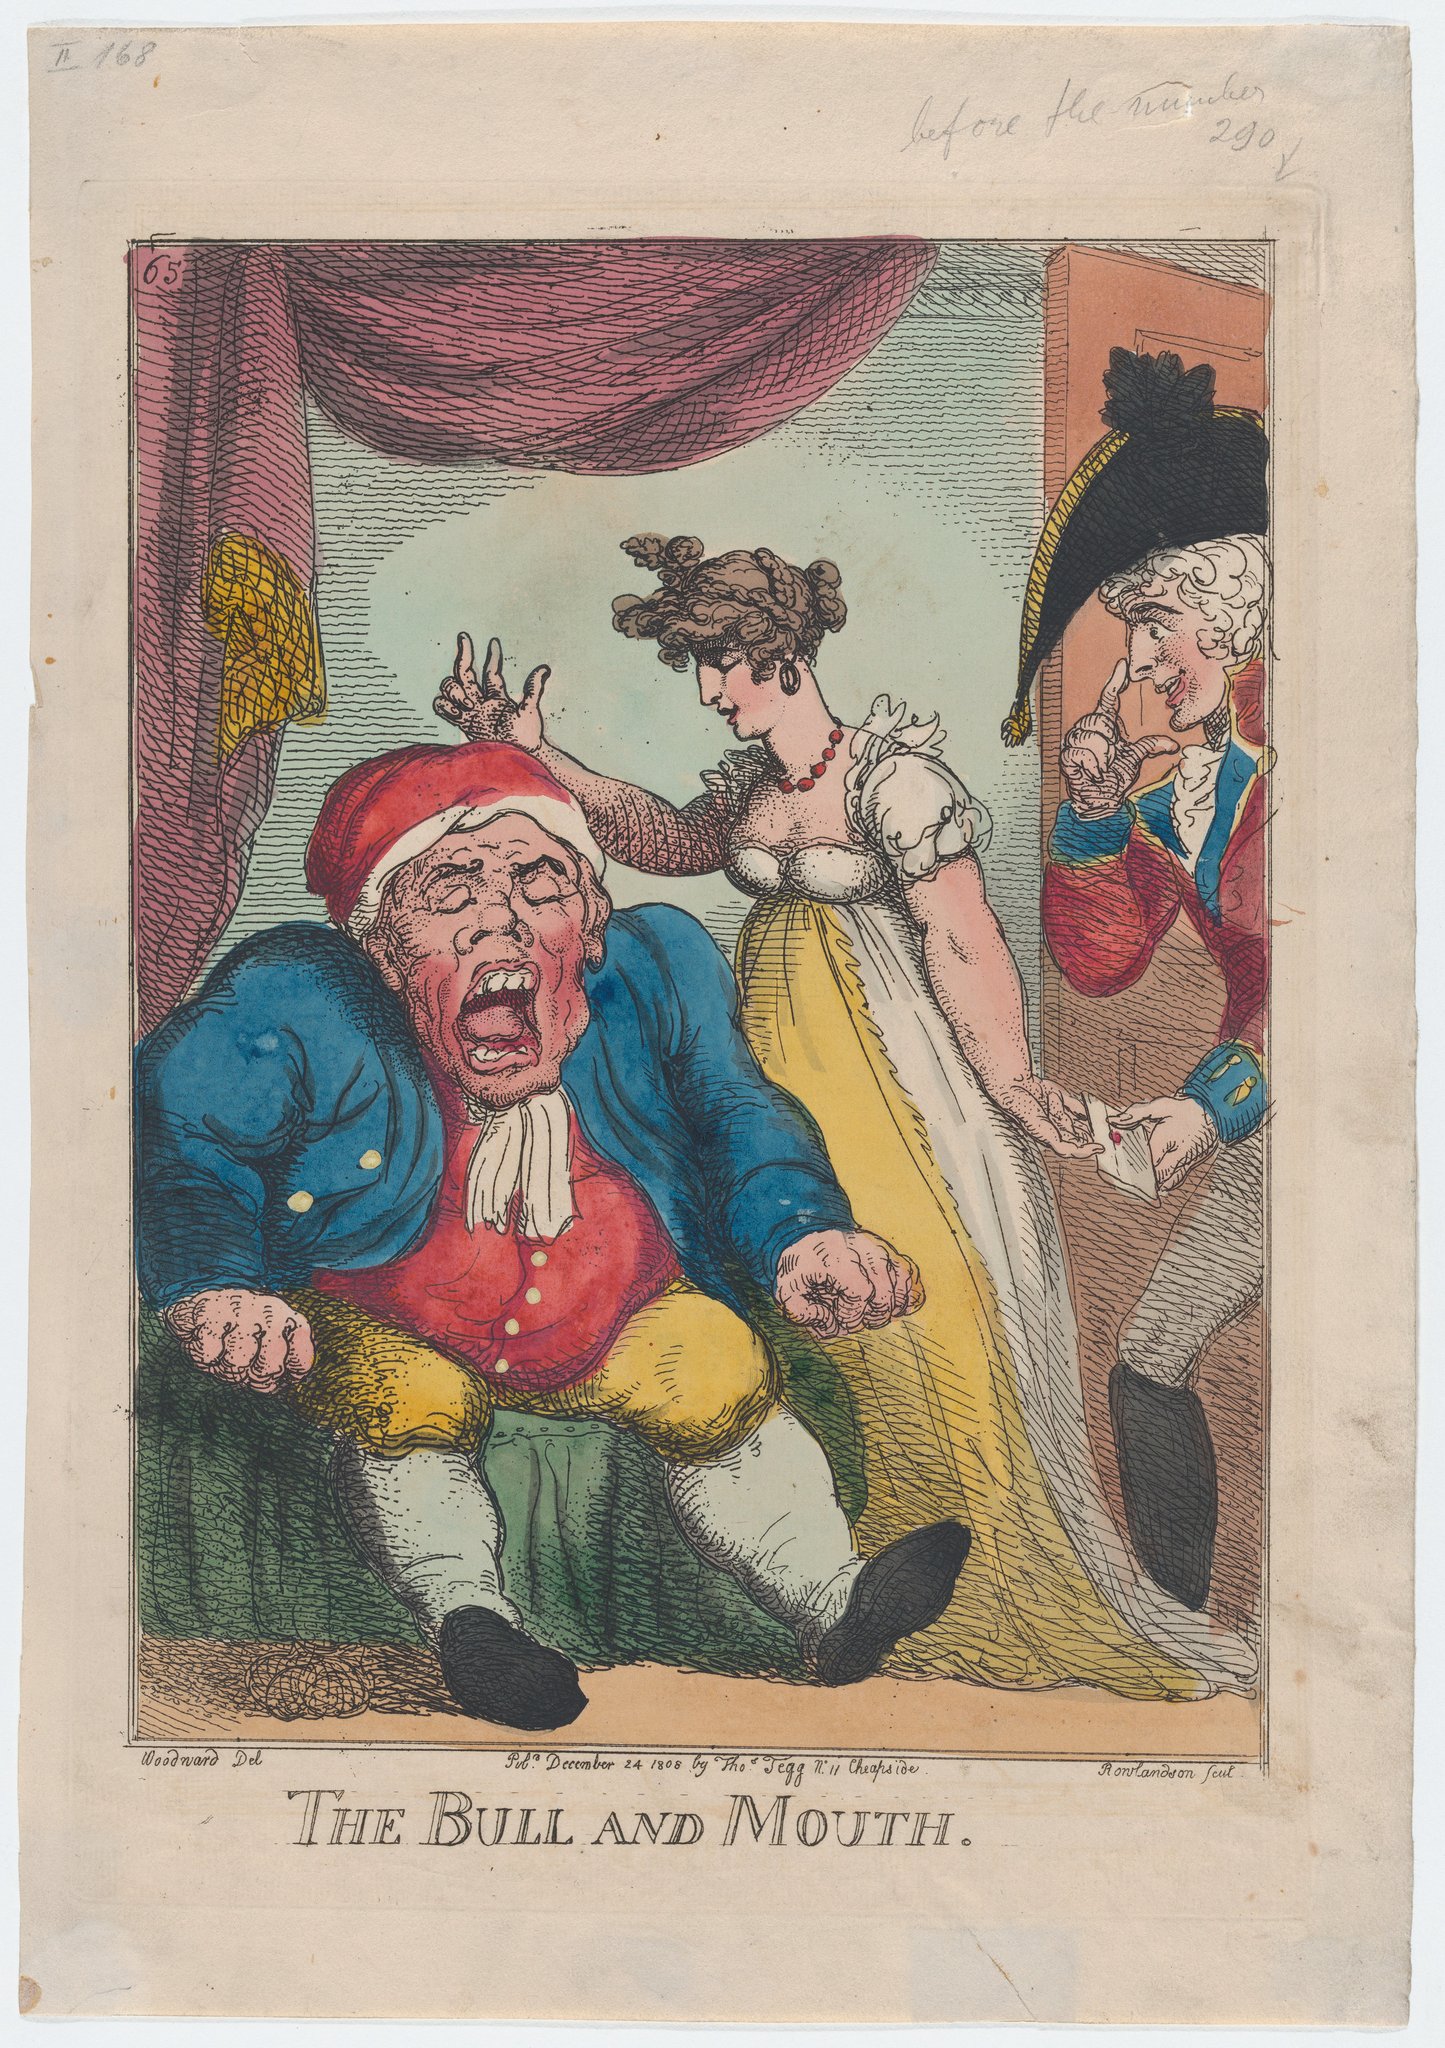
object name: print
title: The Bull and Mouth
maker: thomas rowlandson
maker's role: artist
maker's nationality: british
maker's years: 1757-1827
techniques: etching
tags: satire,men,women